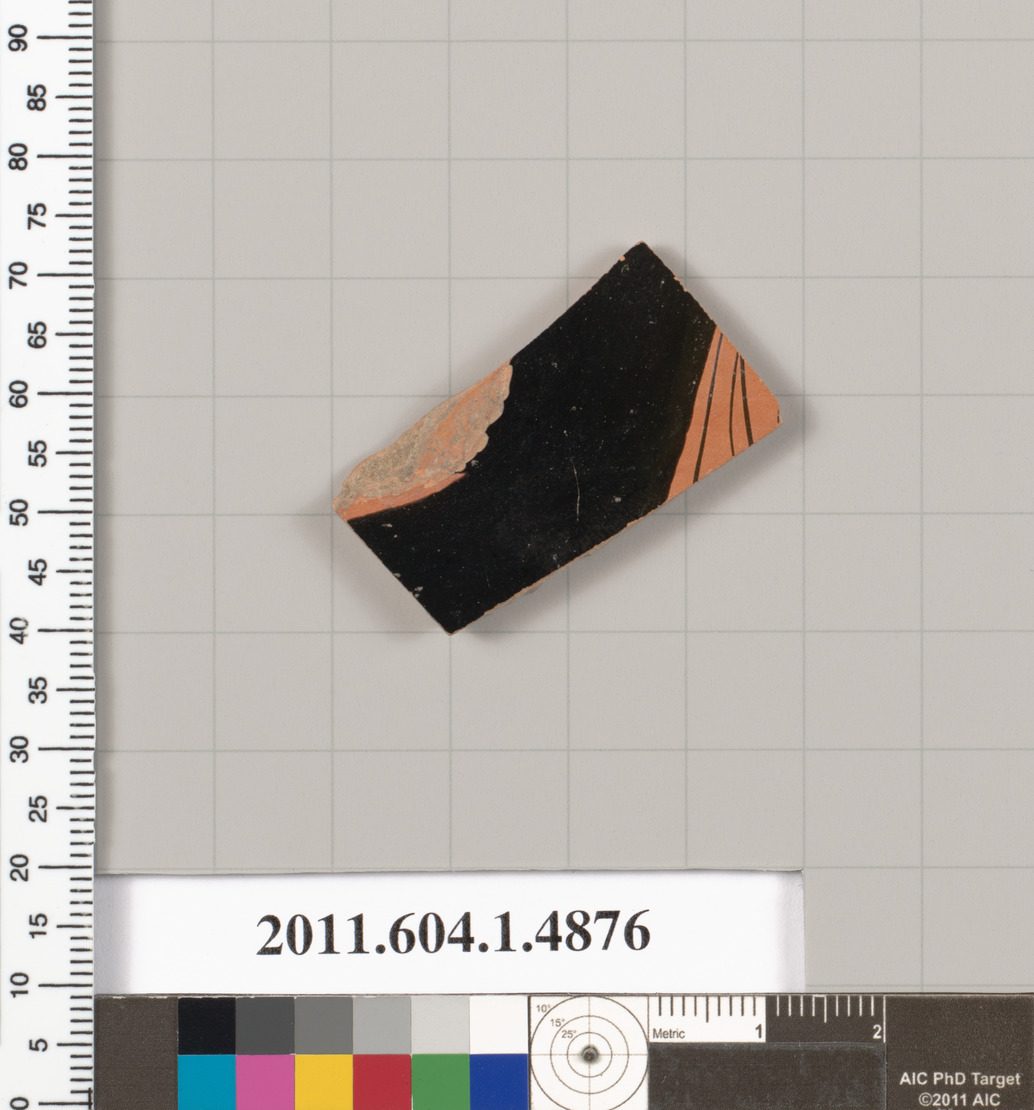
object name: kylix fragment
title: Terracotta fragment of a kylix (drinking cup)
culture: greek, attic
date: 490-470 BCE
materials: terracotta